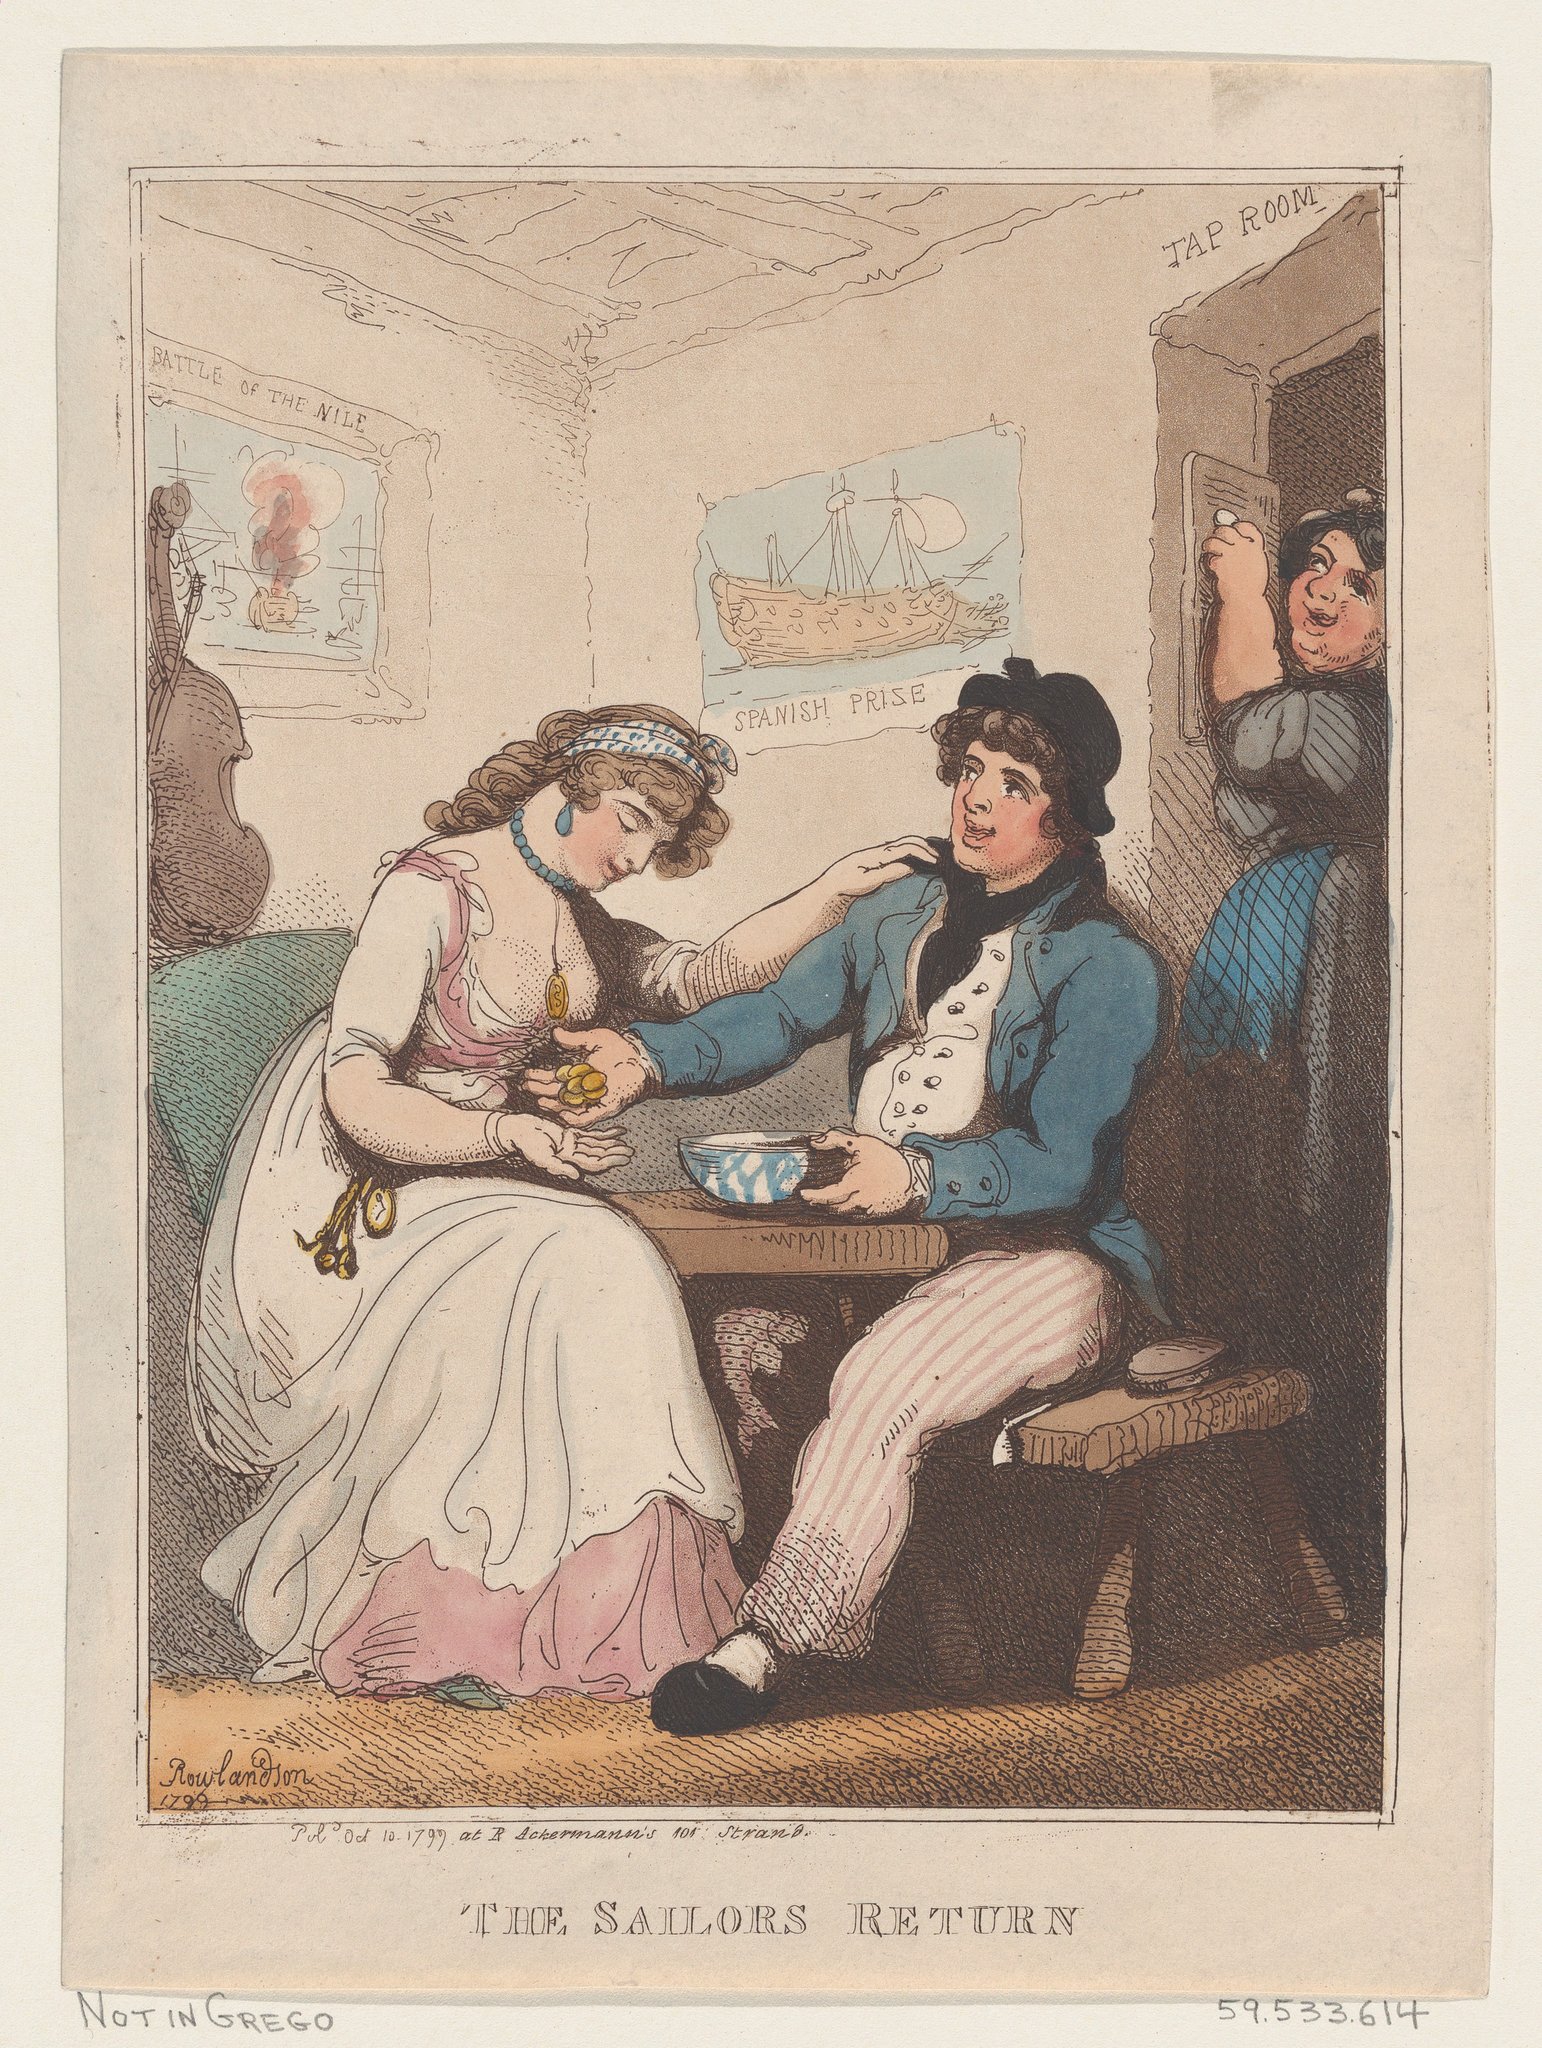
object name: print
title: The Sailor's Return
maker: thomas rowlandson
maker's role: artist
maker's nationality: british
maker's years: 1757-1827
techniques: etching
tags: men,women,sailors